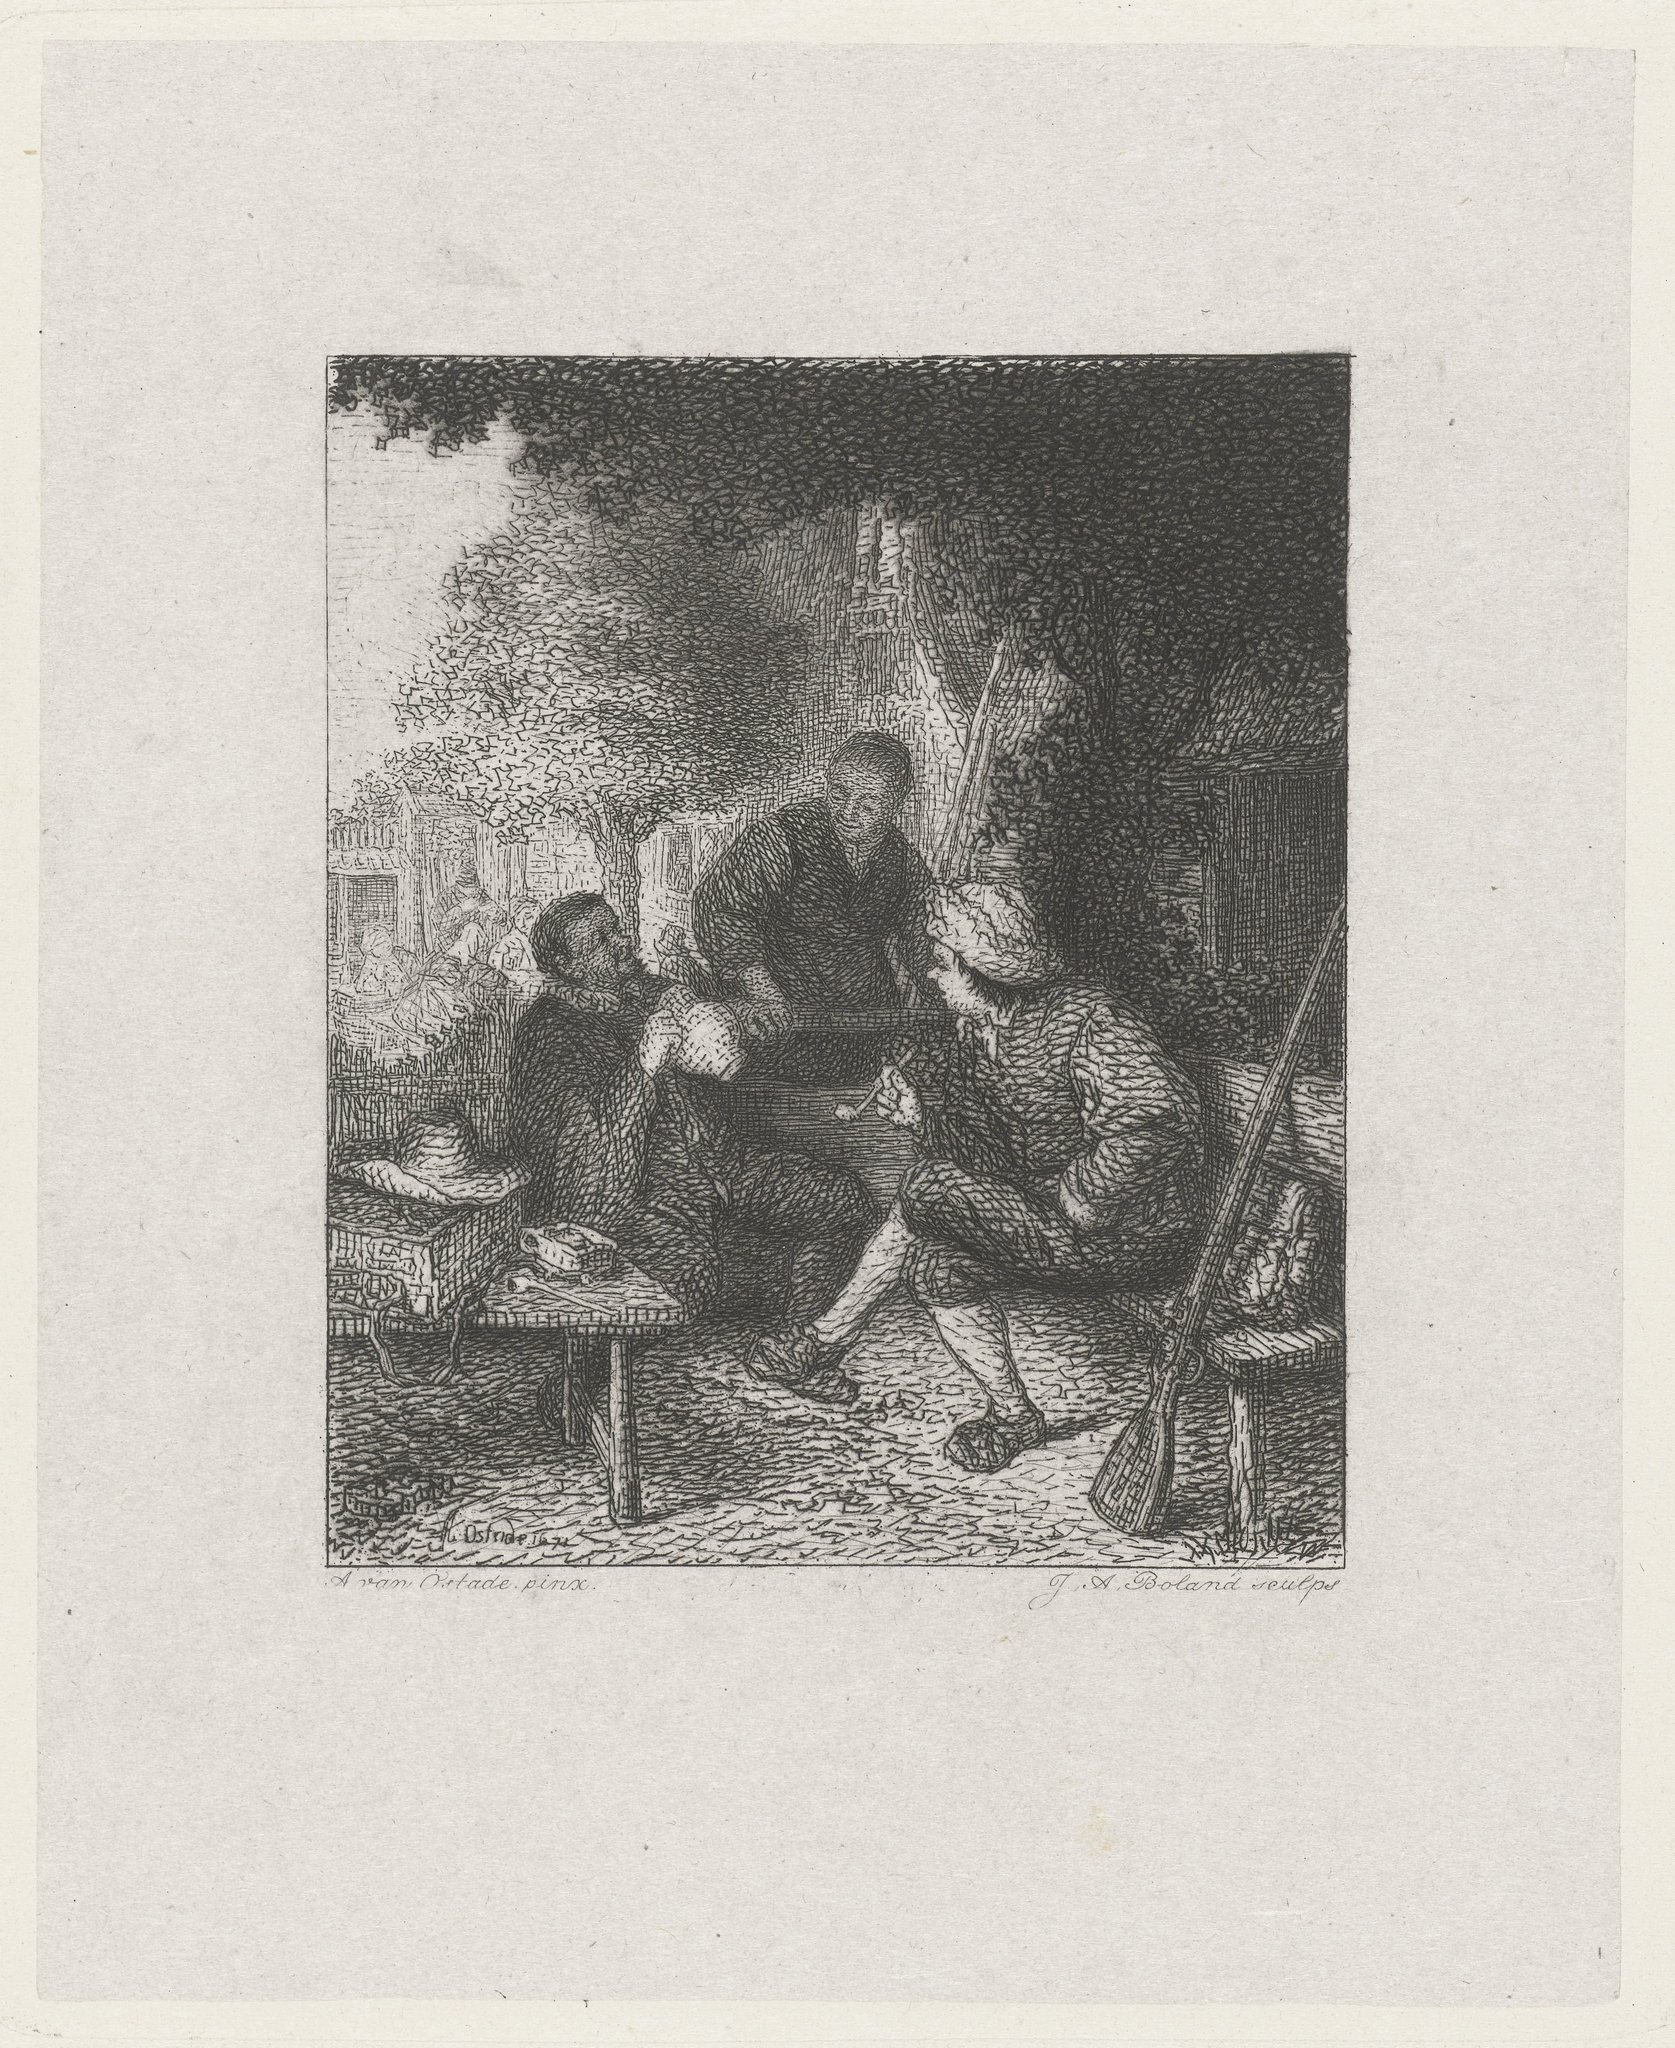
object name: print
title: Rustende reizigers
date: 1875-1876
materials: paper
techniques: etching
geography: amsterdam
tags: (traveller) resting in the open air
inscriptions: collector's mark: Lugt 2228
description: Reproductie van een schilderij uit de collectie van het Rijksmuseum Amsterdam, SK-A-299. Prent afkomstig uit: Brink, J. ten (et al.). Het Rijksmuseum te Amsterdam: [25] etsen van J.A. Boland. Haarlem: J.M. Schalekamp, [1875-1876] (13 A 20).